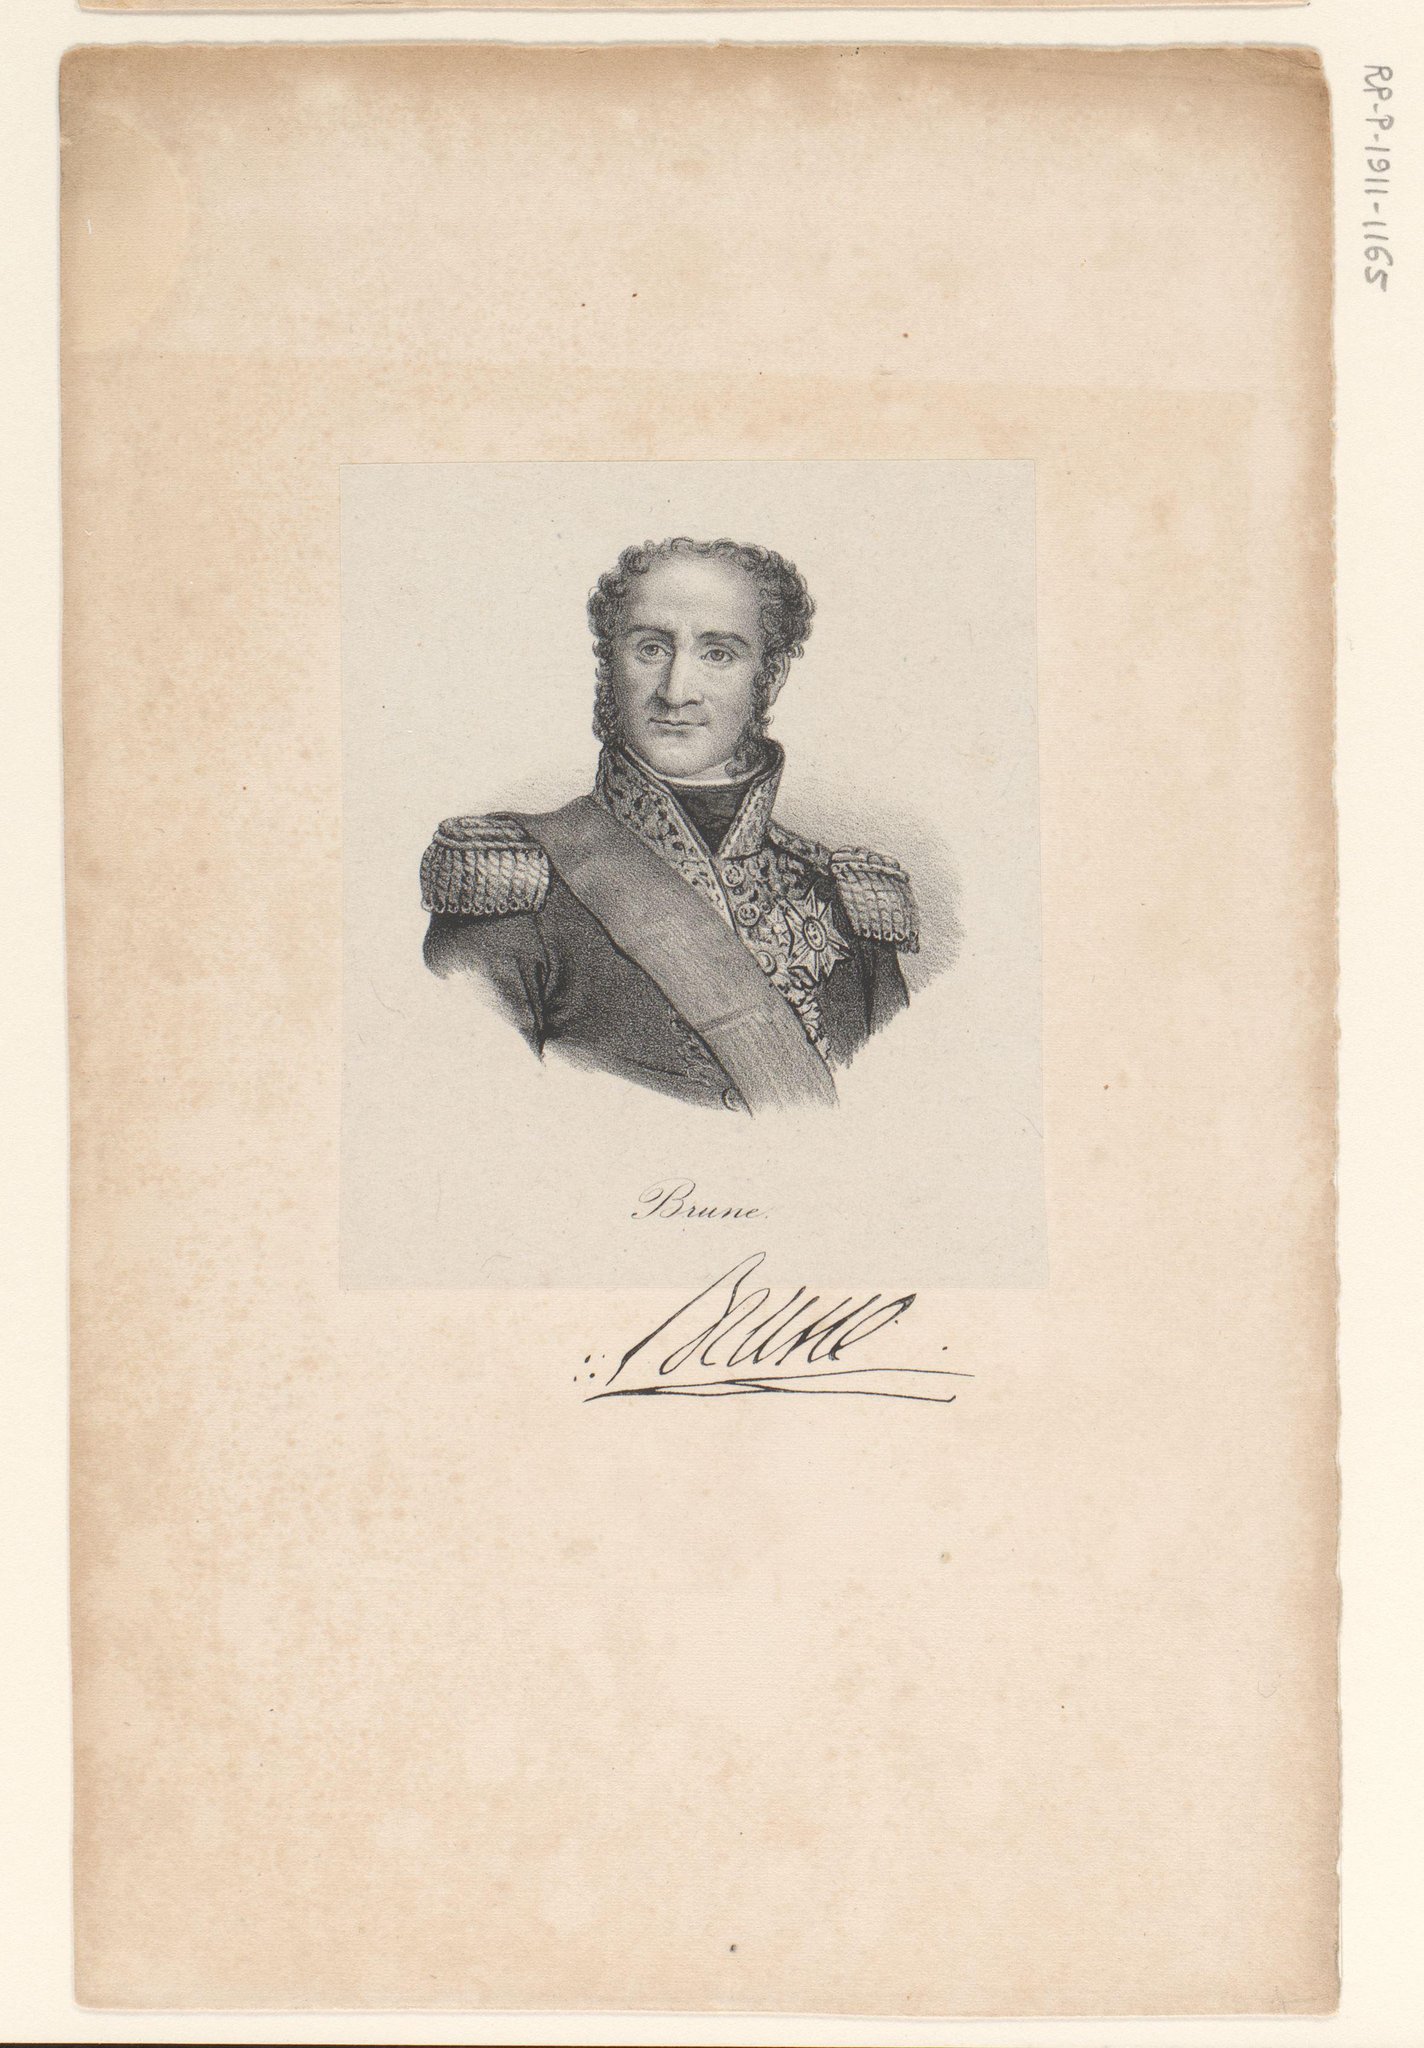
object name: print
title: Portret van Guillaume Brune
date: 1818-1842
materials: paper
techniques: lithograph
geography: paris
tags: historical persons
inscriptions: collector's mark: Lugt 2228a